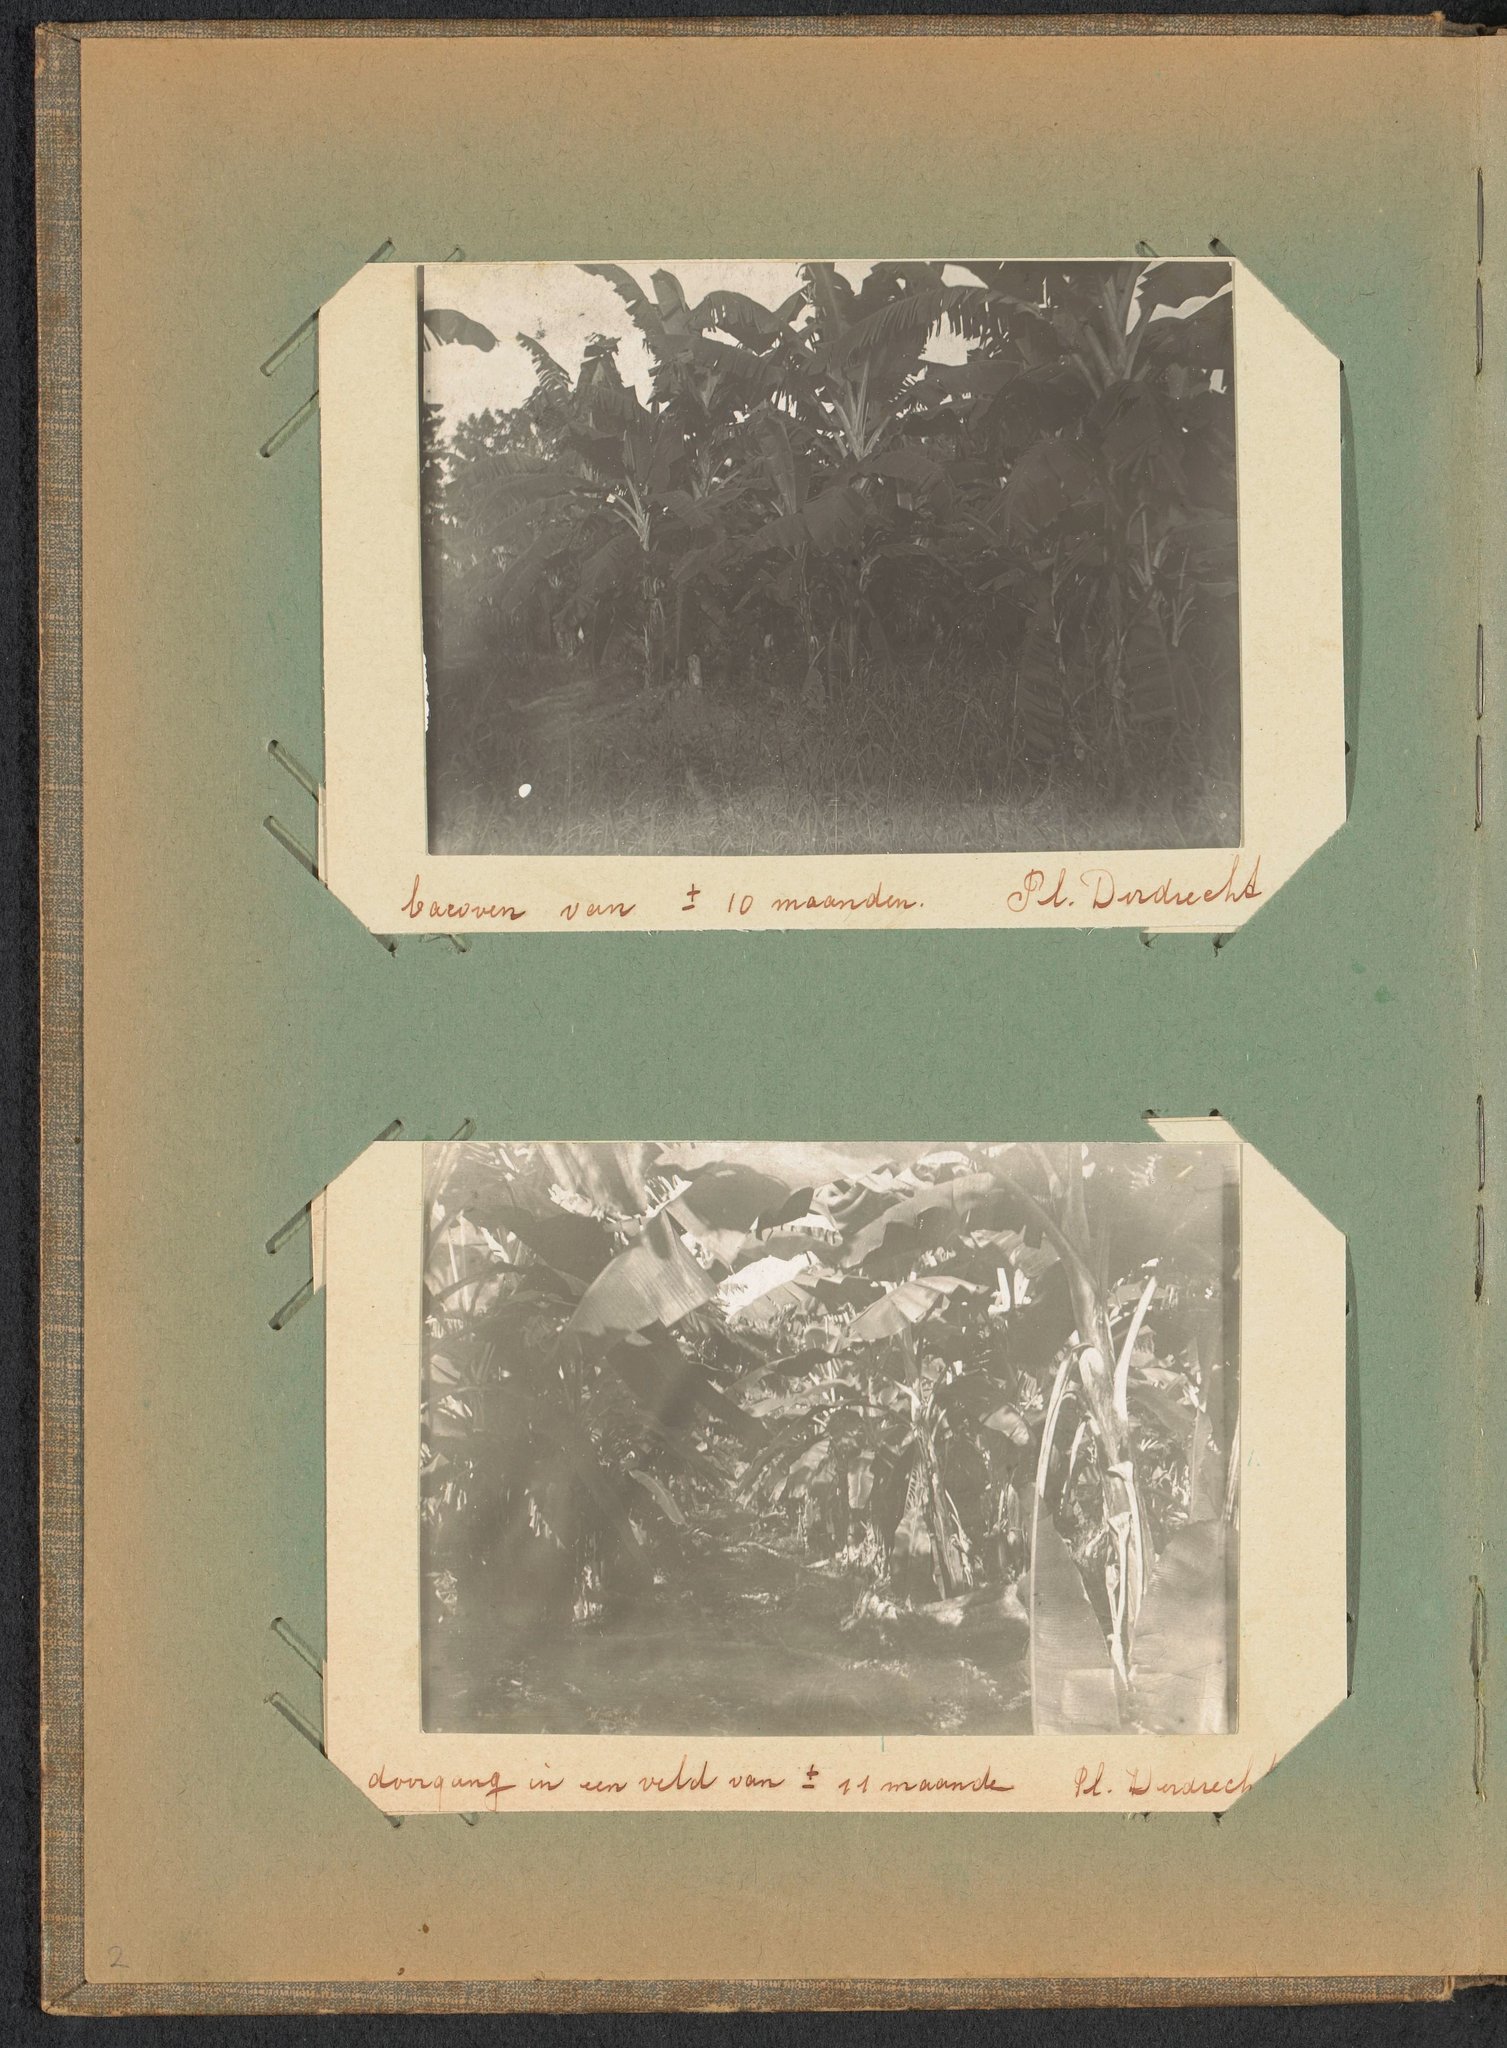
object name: photograph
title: Bananenbomen op Plantage Dordrecht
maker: Anonymous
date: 1912-1913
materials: paper, photographic support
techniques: gelatin silver print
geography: suriname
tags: plantation, fruits: banana, suriname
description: Bananenbomen op Plantage Dordrecht in Suriname. Onderdeel van het fotoalbum uit ca. 1912-1913 met 92 foto's van de plantages Peperpot en Dordrecht in Suriname en Mount Pleasant op Curaçao.